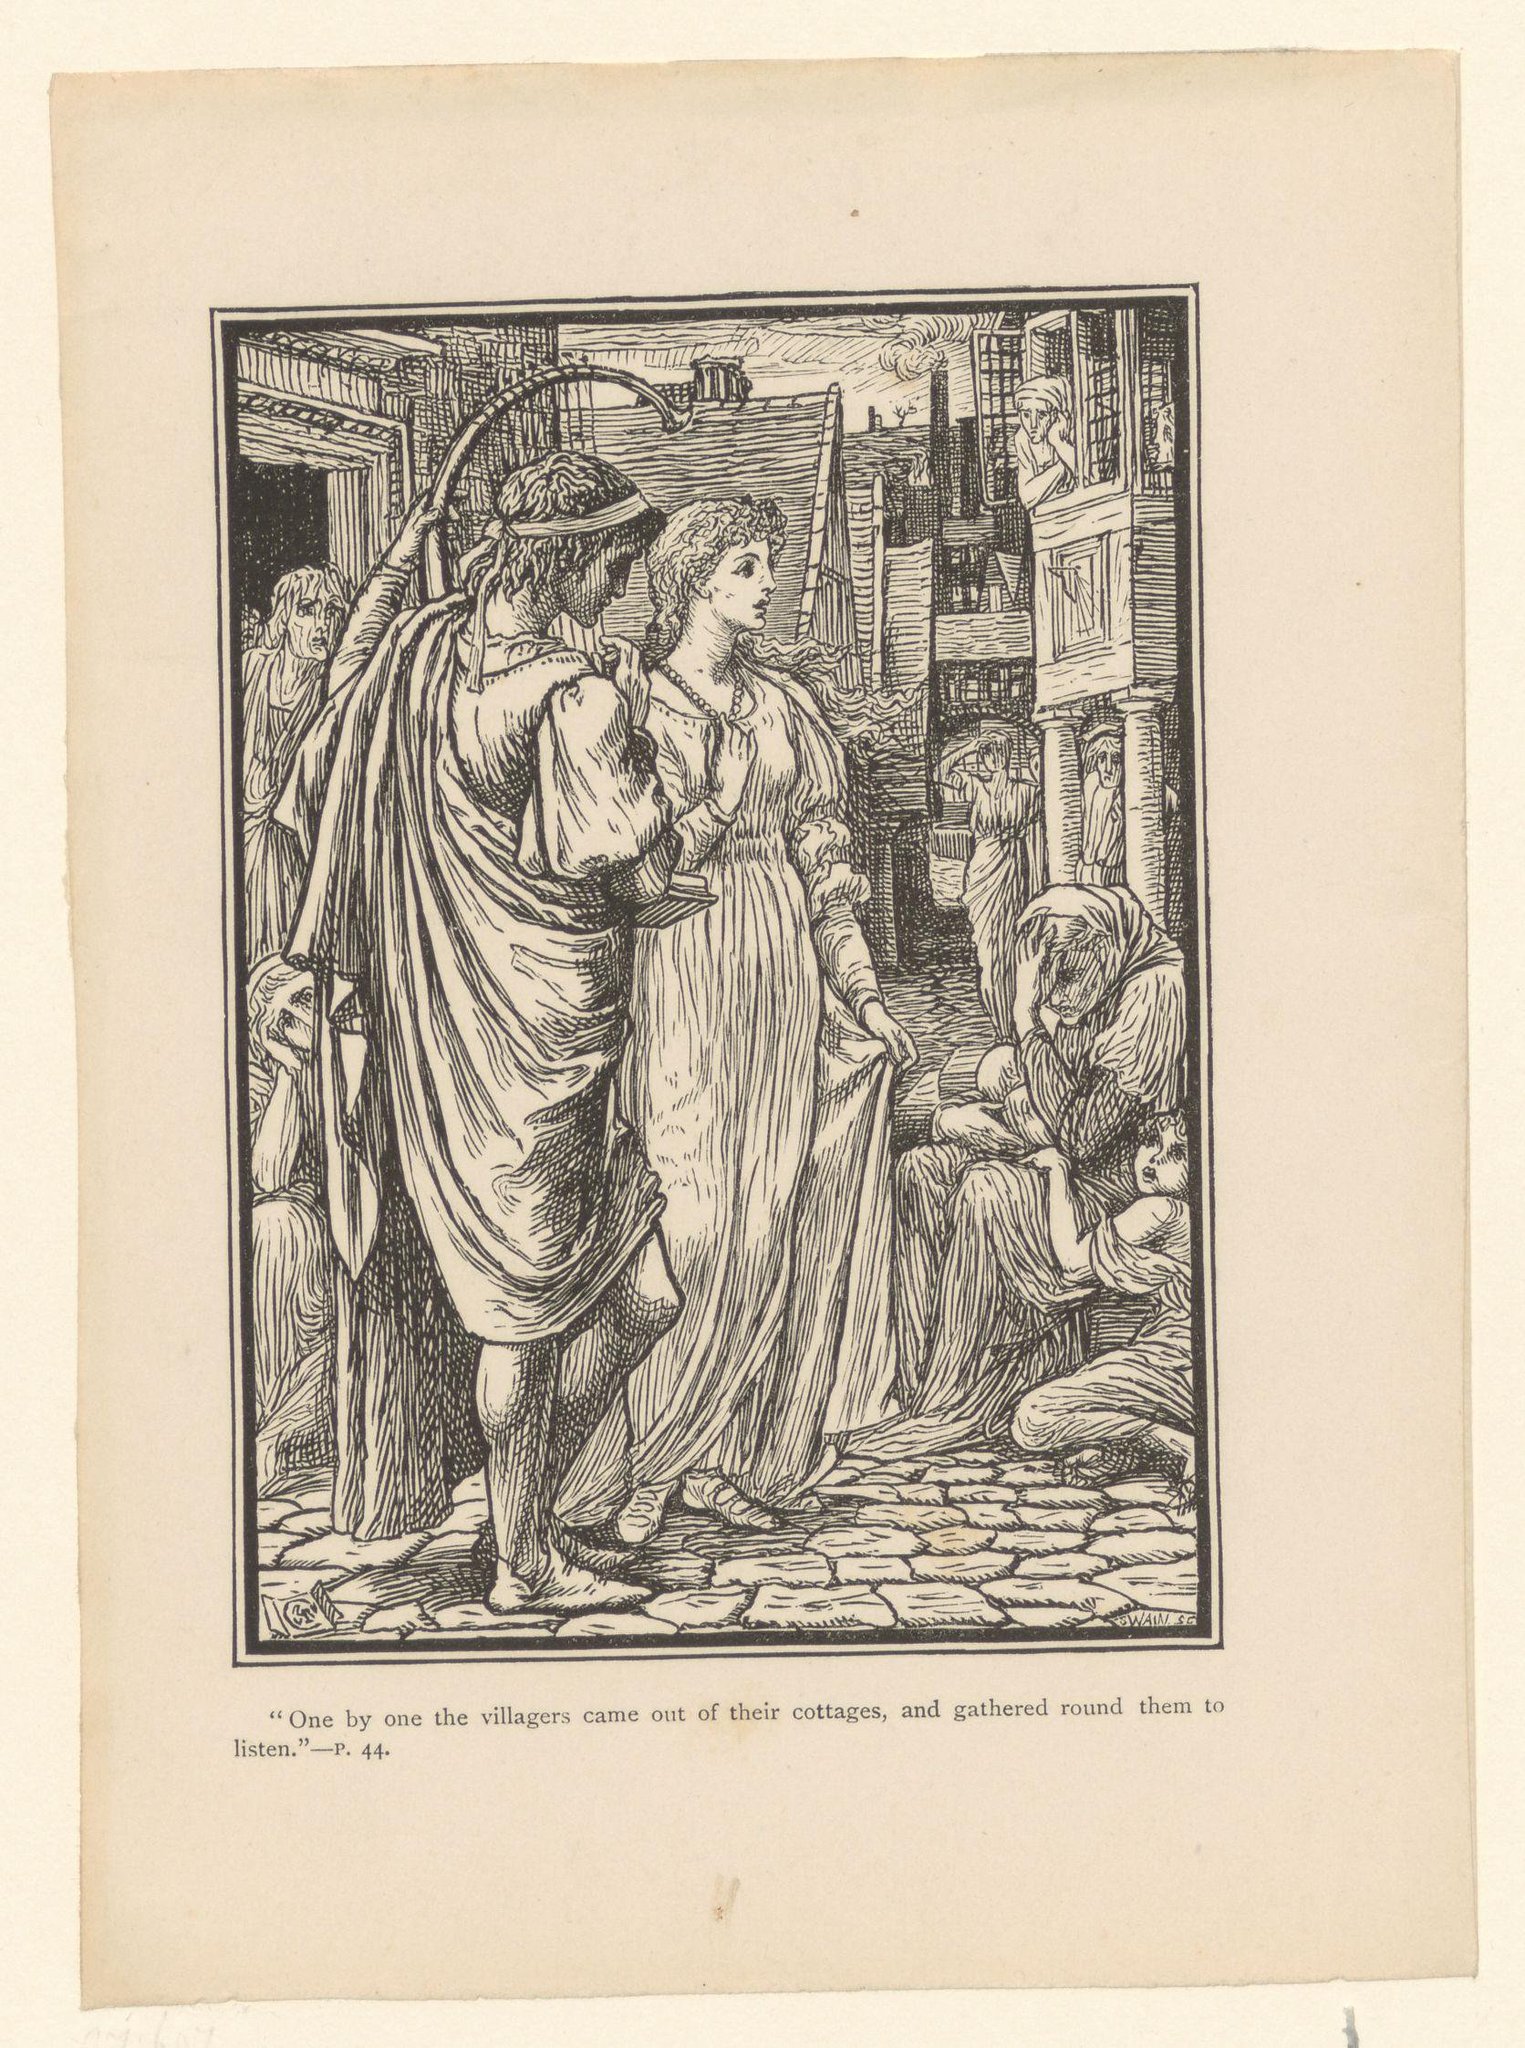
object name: print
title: Fiorimonde loopt op straat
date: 1886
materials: paper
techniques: letterpress printing, engraving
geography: london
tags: princess, necklace, street (+ city(-scape) with figures, staffage)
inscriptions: collector's mark: Lugt 2228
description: Prent uit: Morgan, Mary de. The necklace of princess Fiorimonde and other stories by May de Morgan. Londen: Macmillan & Co., 1886, p. 44.